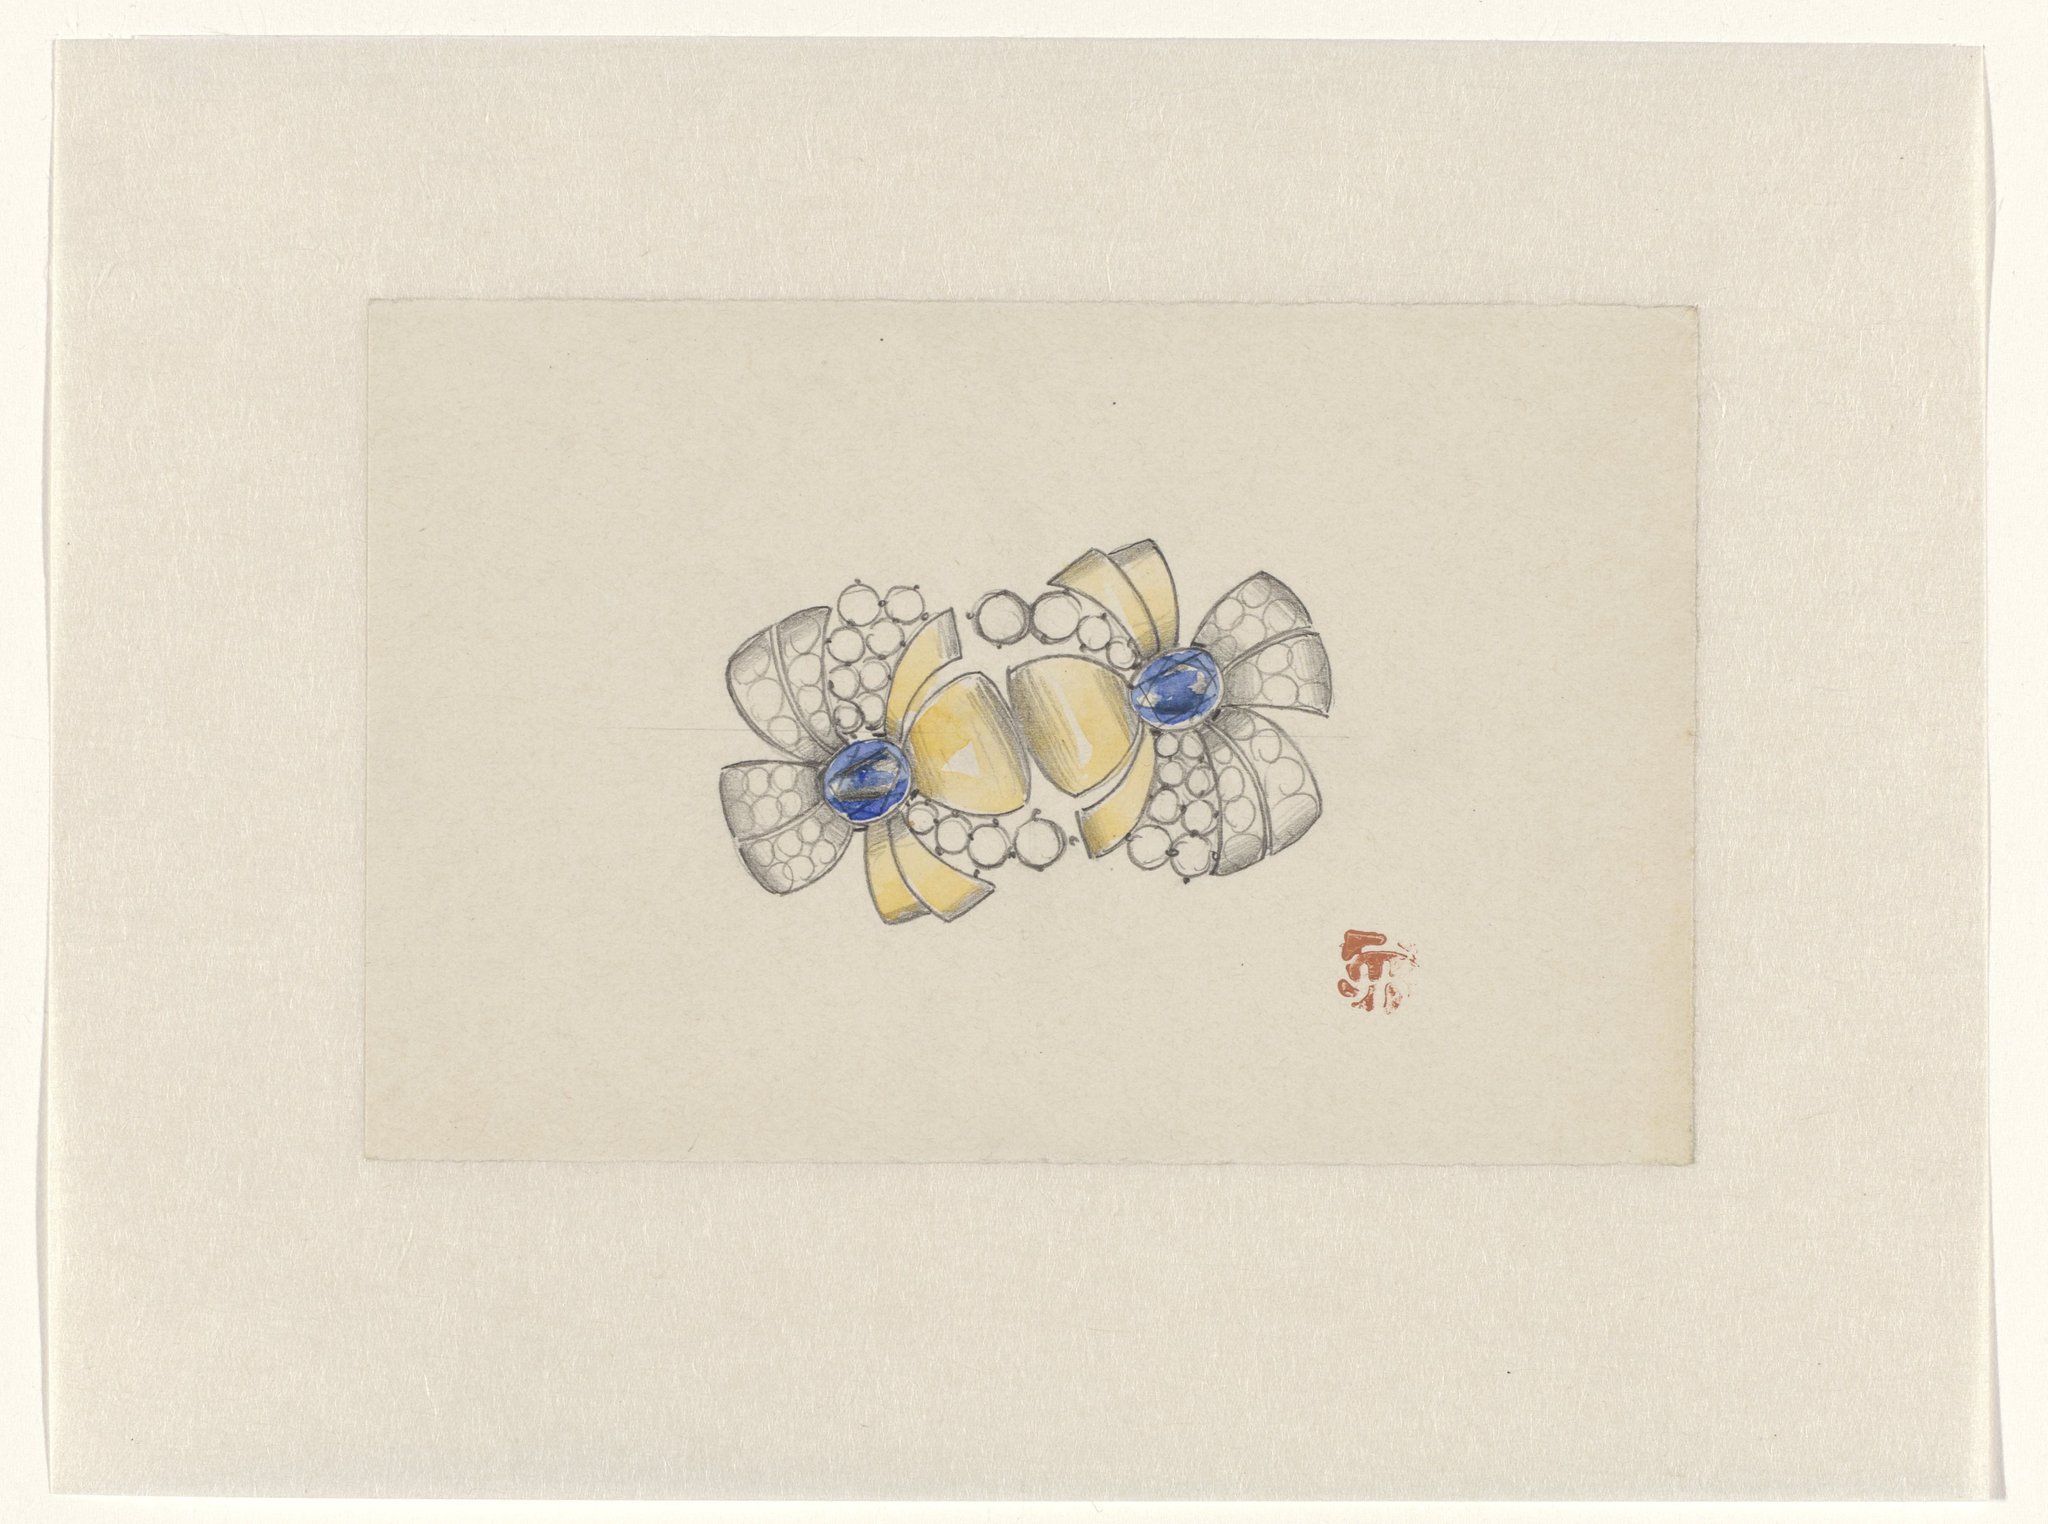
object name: drawing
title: Ontwerp voor juweel in de vorm van twee gestileerde bloemen, met goud en saffieren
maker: jules chadel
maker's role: draughtsman, print maker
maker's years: 1870-1941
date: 1920-1930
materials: paper, pencil, watercolor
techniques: brush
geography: paris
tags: ornaments, jewels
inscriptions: stamp: Lugt 562 b